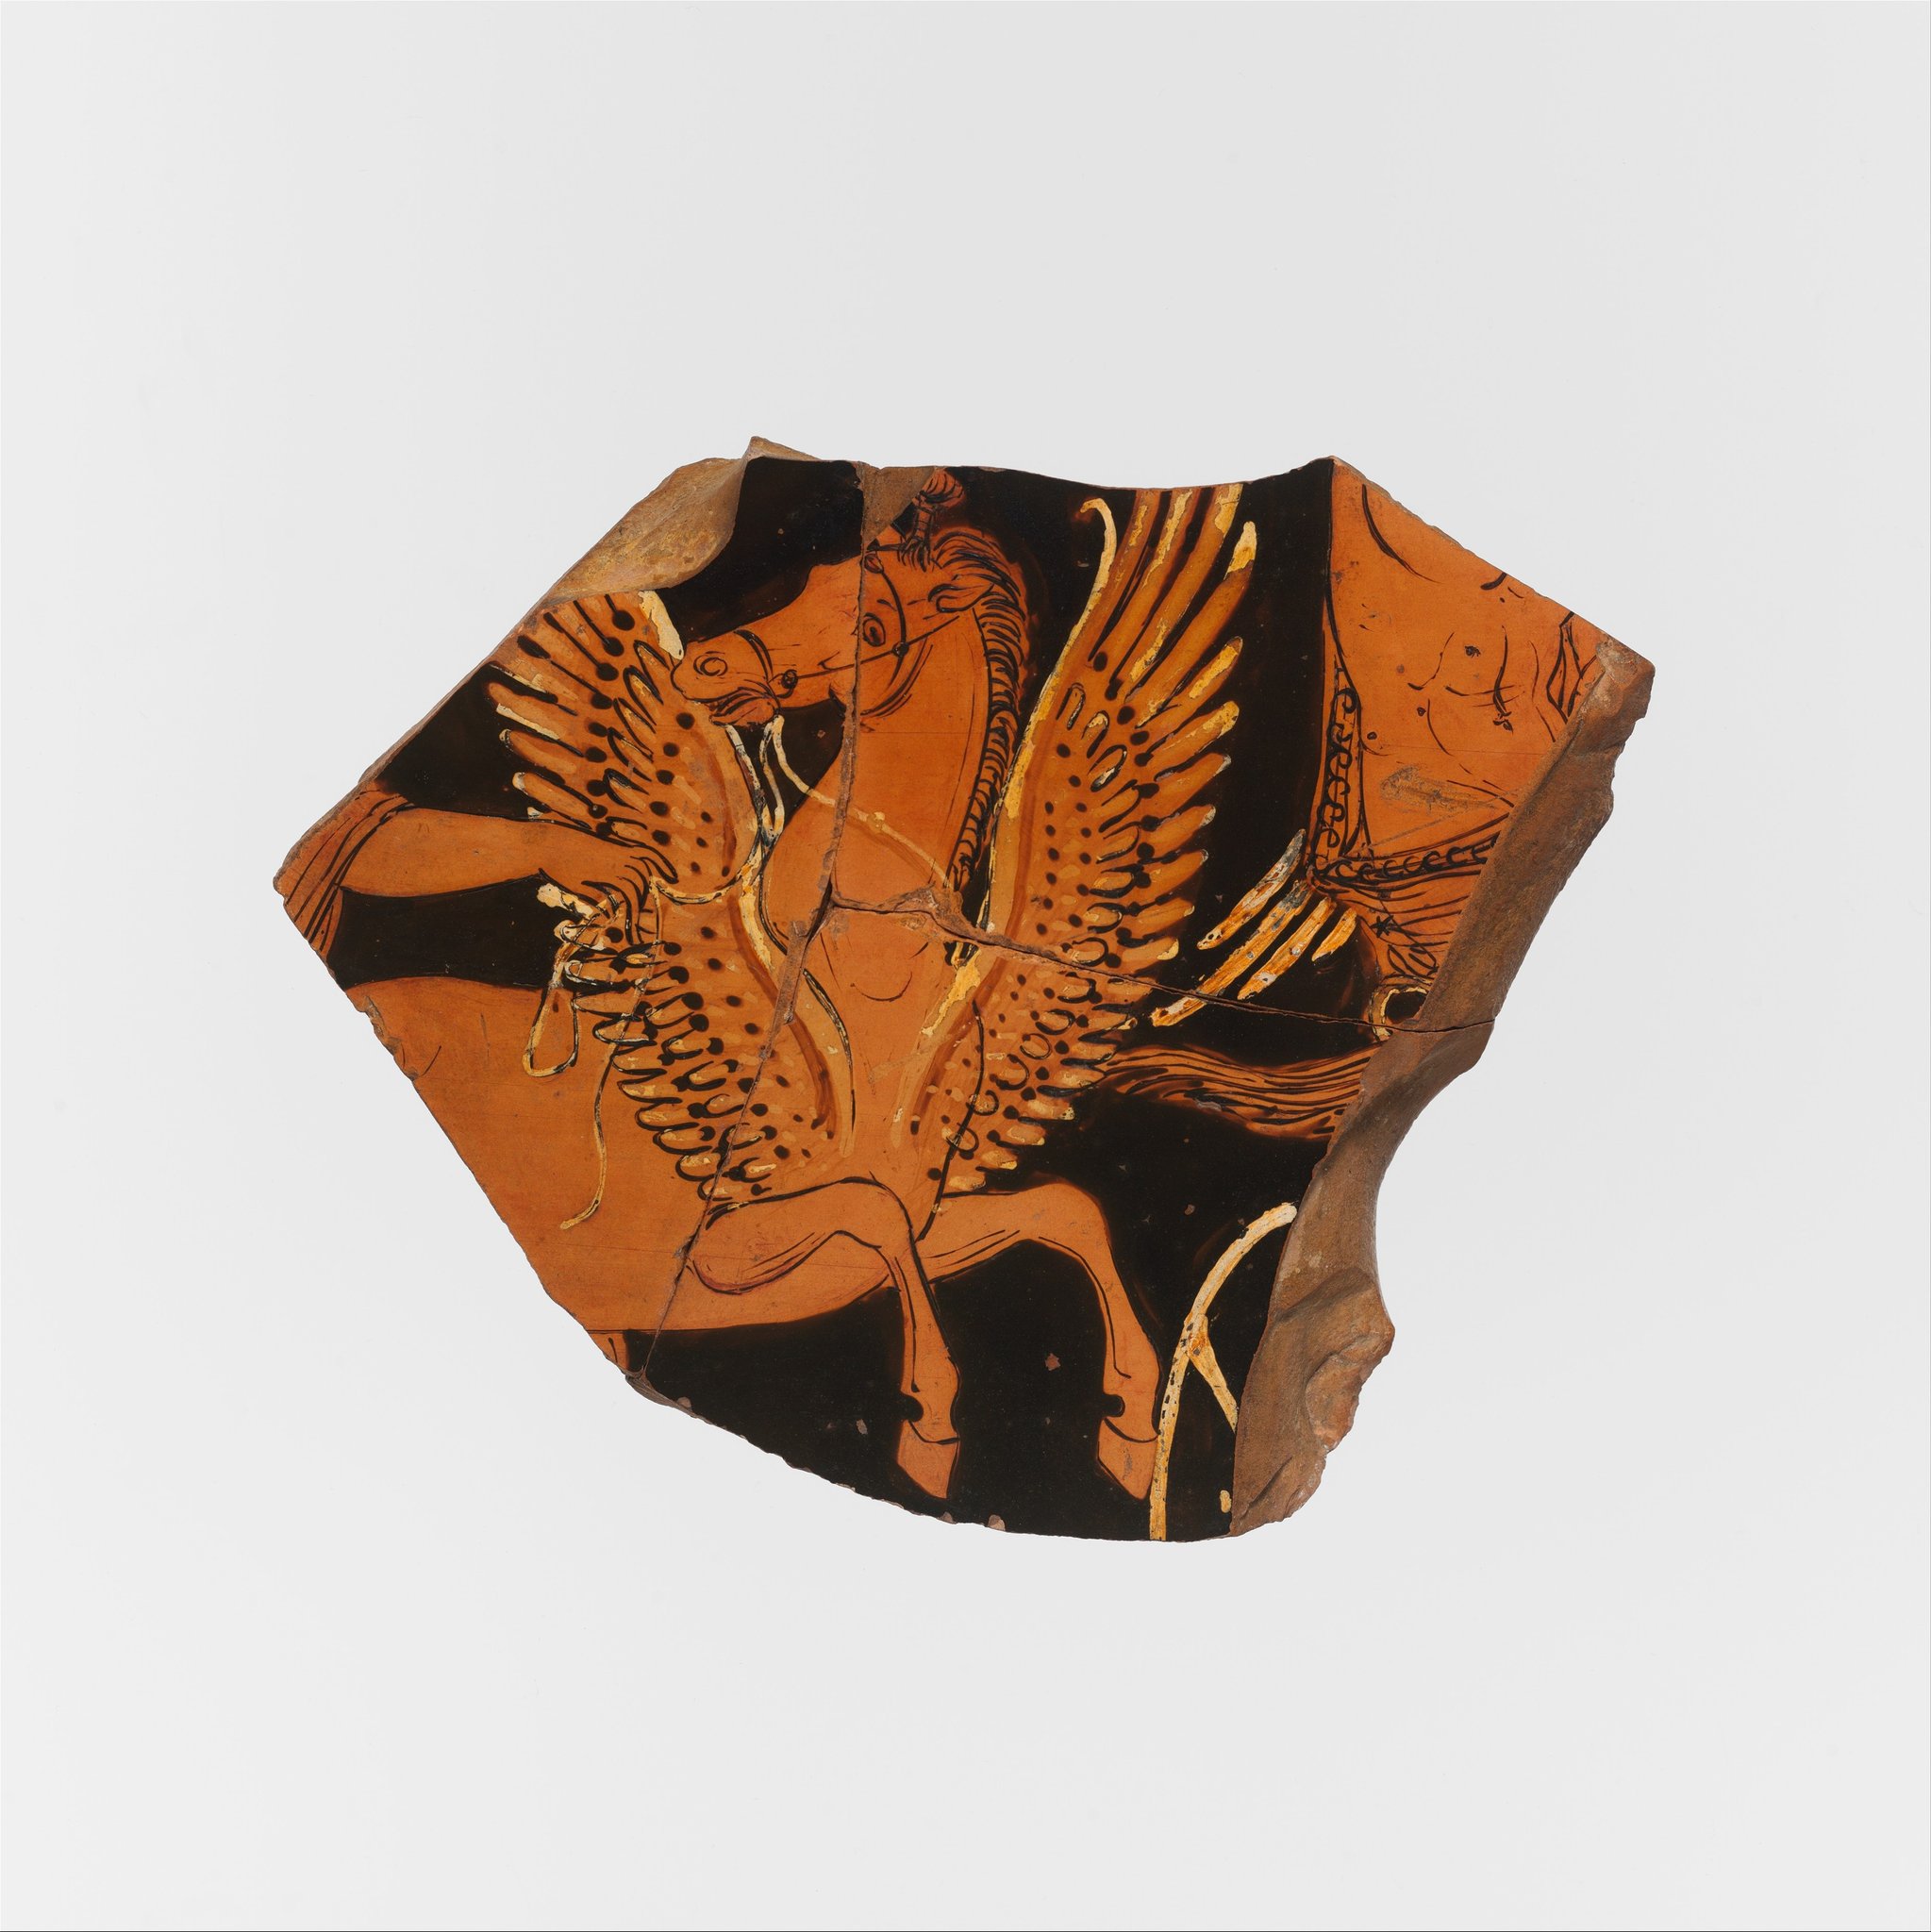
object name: volute krater fragment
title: Fragment of a terracotta volute-krater (bowl for mixing wine and water)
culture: greek, south italian, apulian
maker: painter of the dublin situlae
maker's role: artist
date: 367-335 BCE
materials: terracotta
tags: hands,pegasus